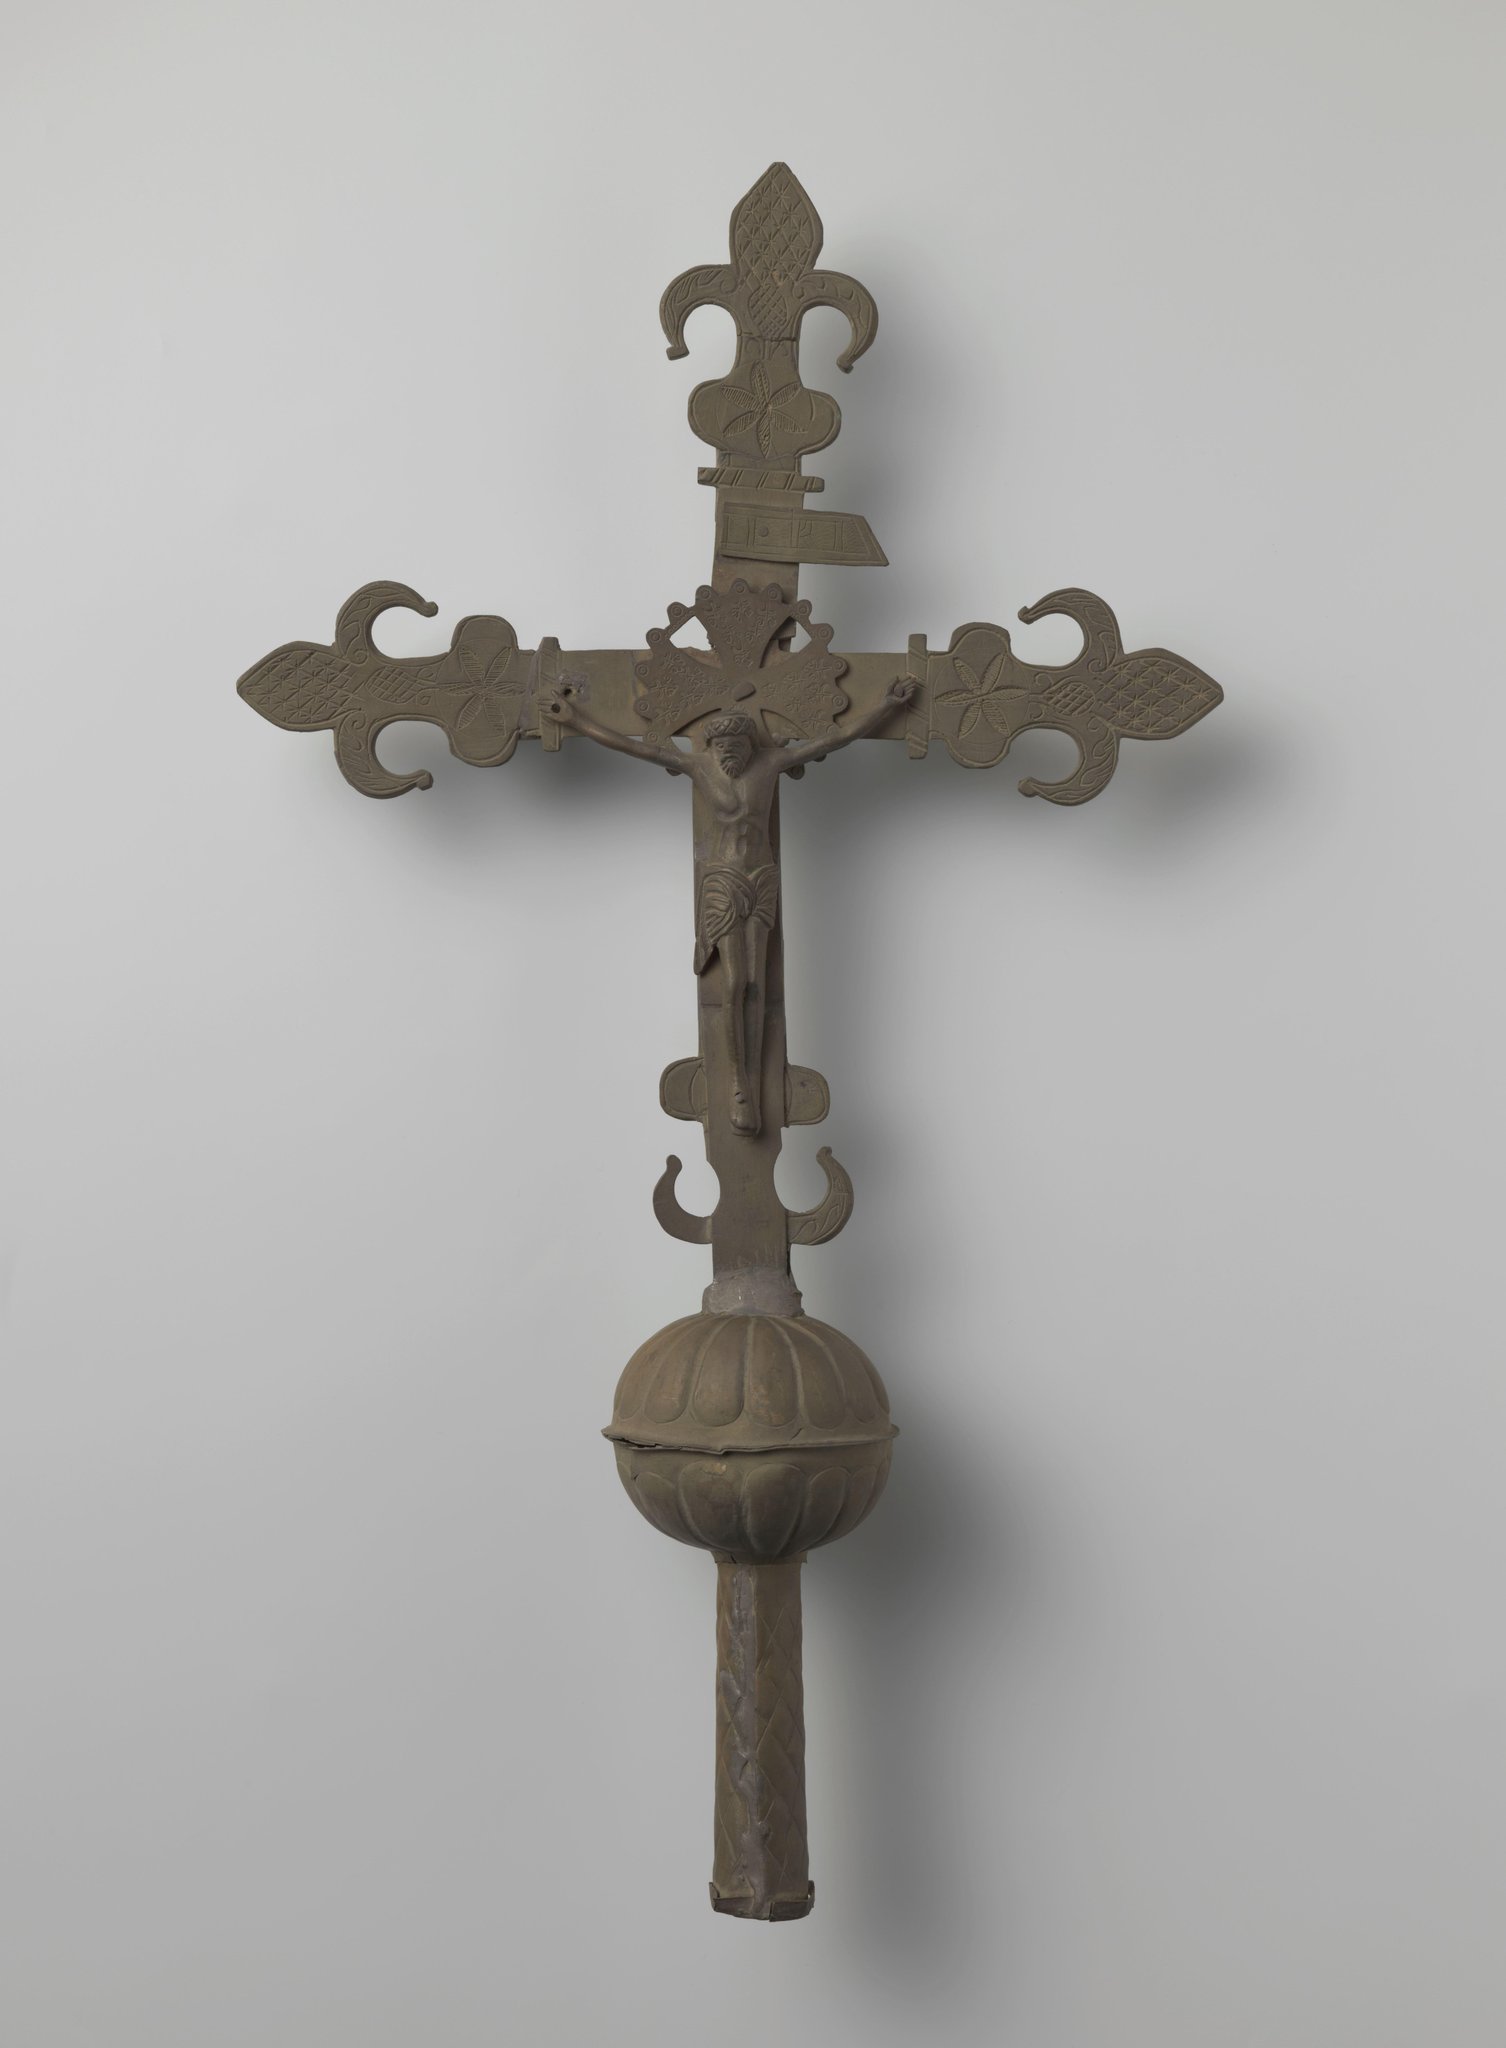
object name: processional cross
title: Processiekruis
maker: Anonymous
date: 1600-1699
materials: brass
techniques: engraving, punching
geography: southern netherlands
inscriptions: inscription: ‘I.N.R.I.’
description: Het ingrijpend herstelde voorwerp is uit een groot aantal onderdelen opgebouwd, onder andere het uit koperplaat vervaardigde deel om het geheel op een staf te kunnen plaatsen, de uit koperplaat gemaakte uit twee helften bestaande met godrons versierde nodus en het daarop gesoldeerde kruis, dat aan de achterkant eveneens vele malen is gerepareerd. De einden zijn versierd met Franse lelies in een vaasvormige voet, opgevuld met gegraveerd ornament. Het aureool, dat op de kruising is aangebracht, heeft een geponst ornament. Aan de voorkant de gekruisigde Christus. De afkorting I.N.R.I. is ten dele afgebroken.